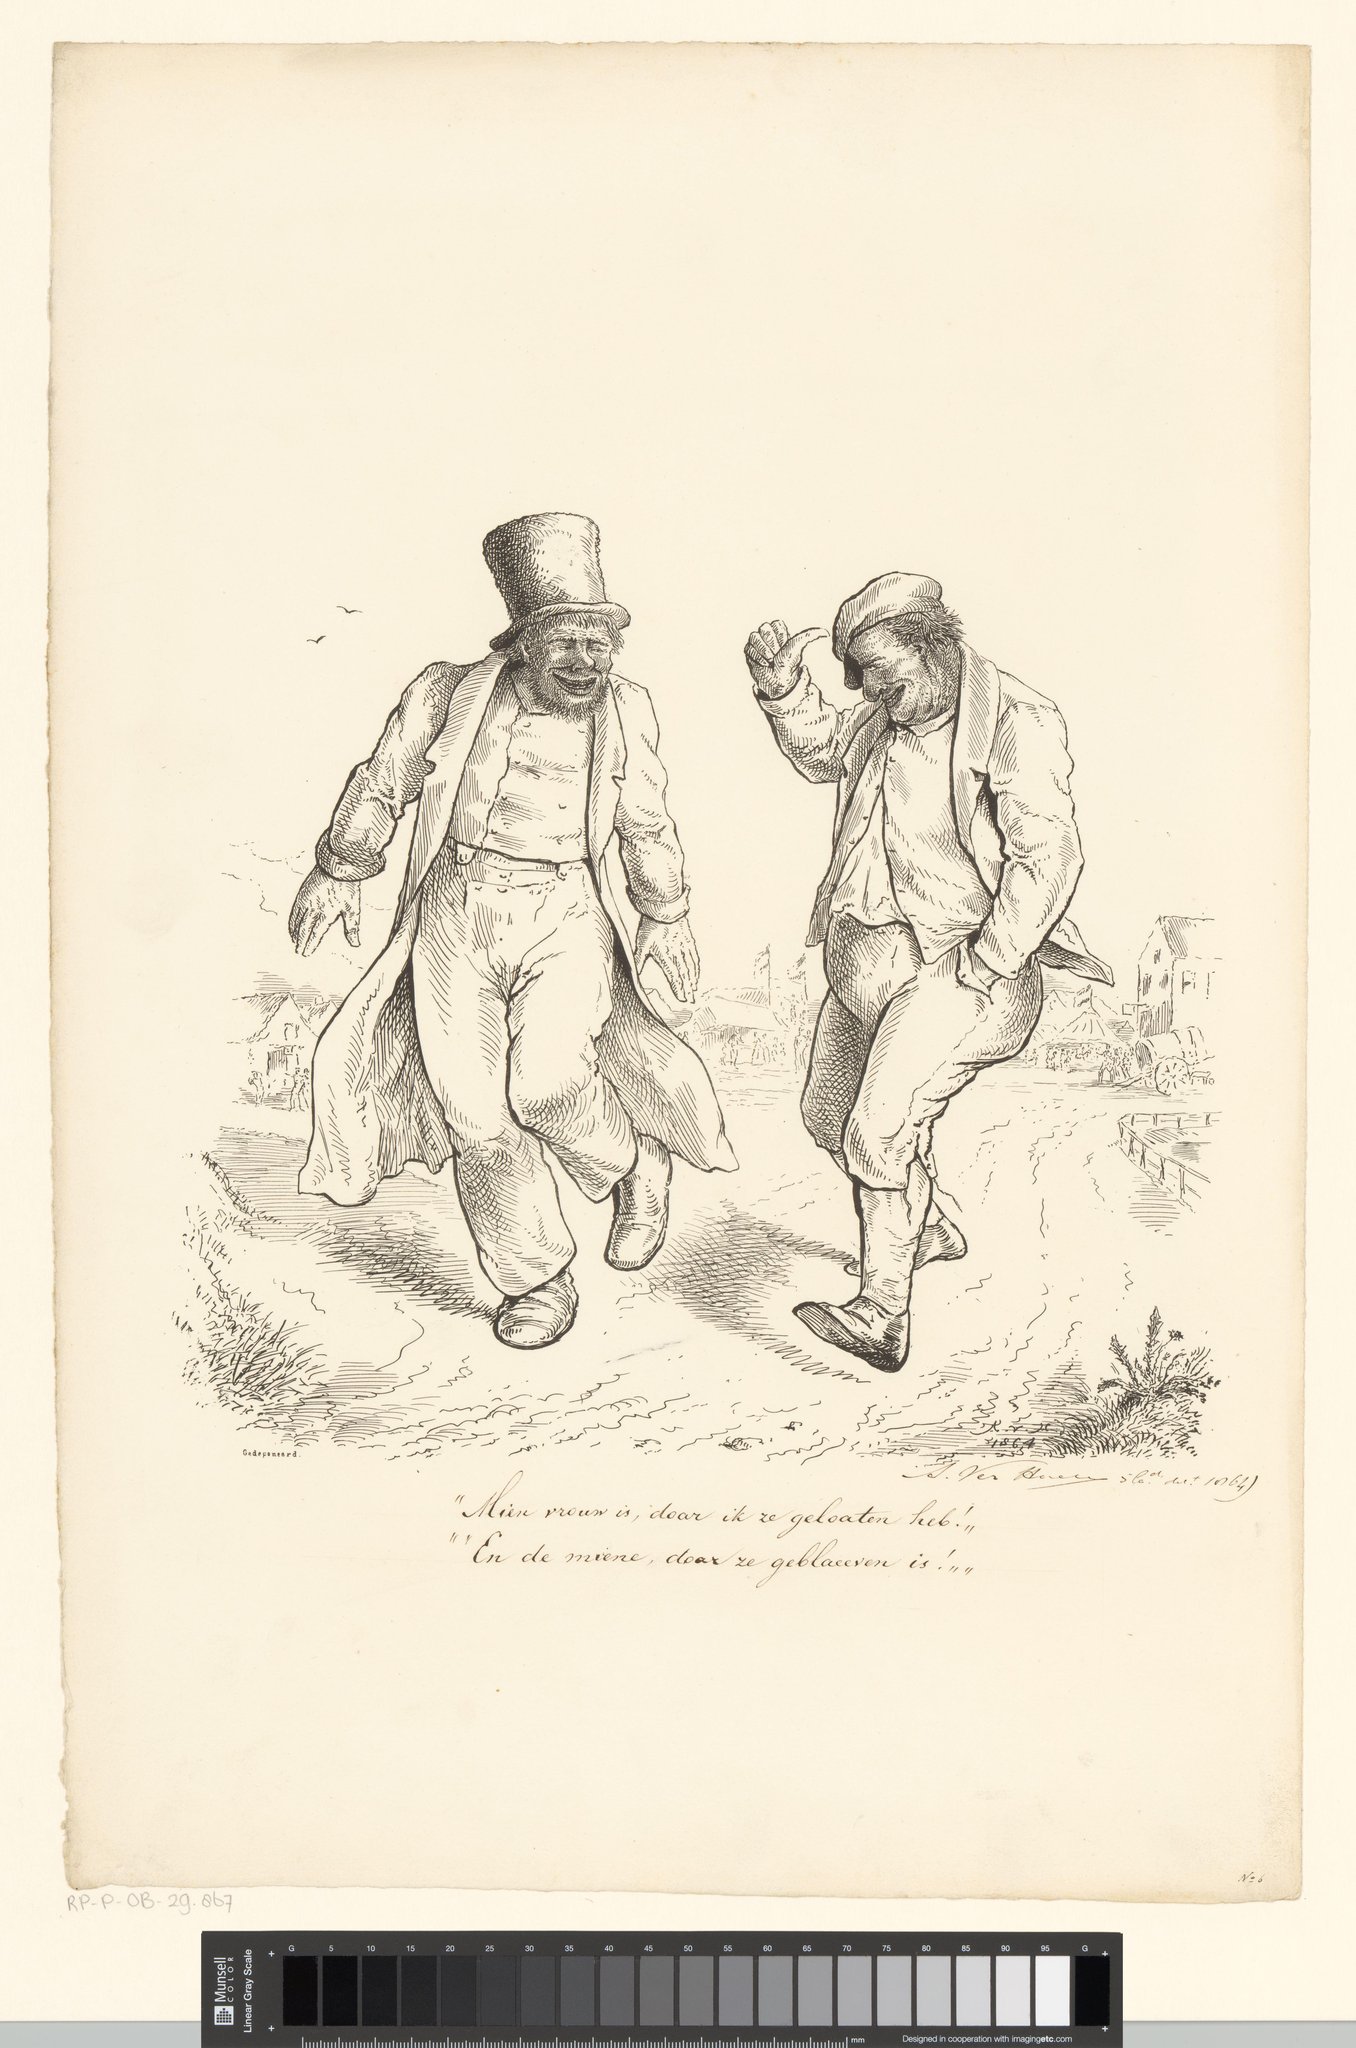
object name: print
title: Uit het verleden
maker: alexander ver huell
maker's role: draughtsman, print maker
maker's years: 1822-1897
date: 1864-1866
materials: paper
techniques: lithograph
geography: arnhem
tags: laughing, pleasure fair and circus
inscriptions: collector's mark: Lugt 2228, : ‘Gedeponeerd.’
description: Twee lachende mannen lopen weg van de kermis in de achtergrond.